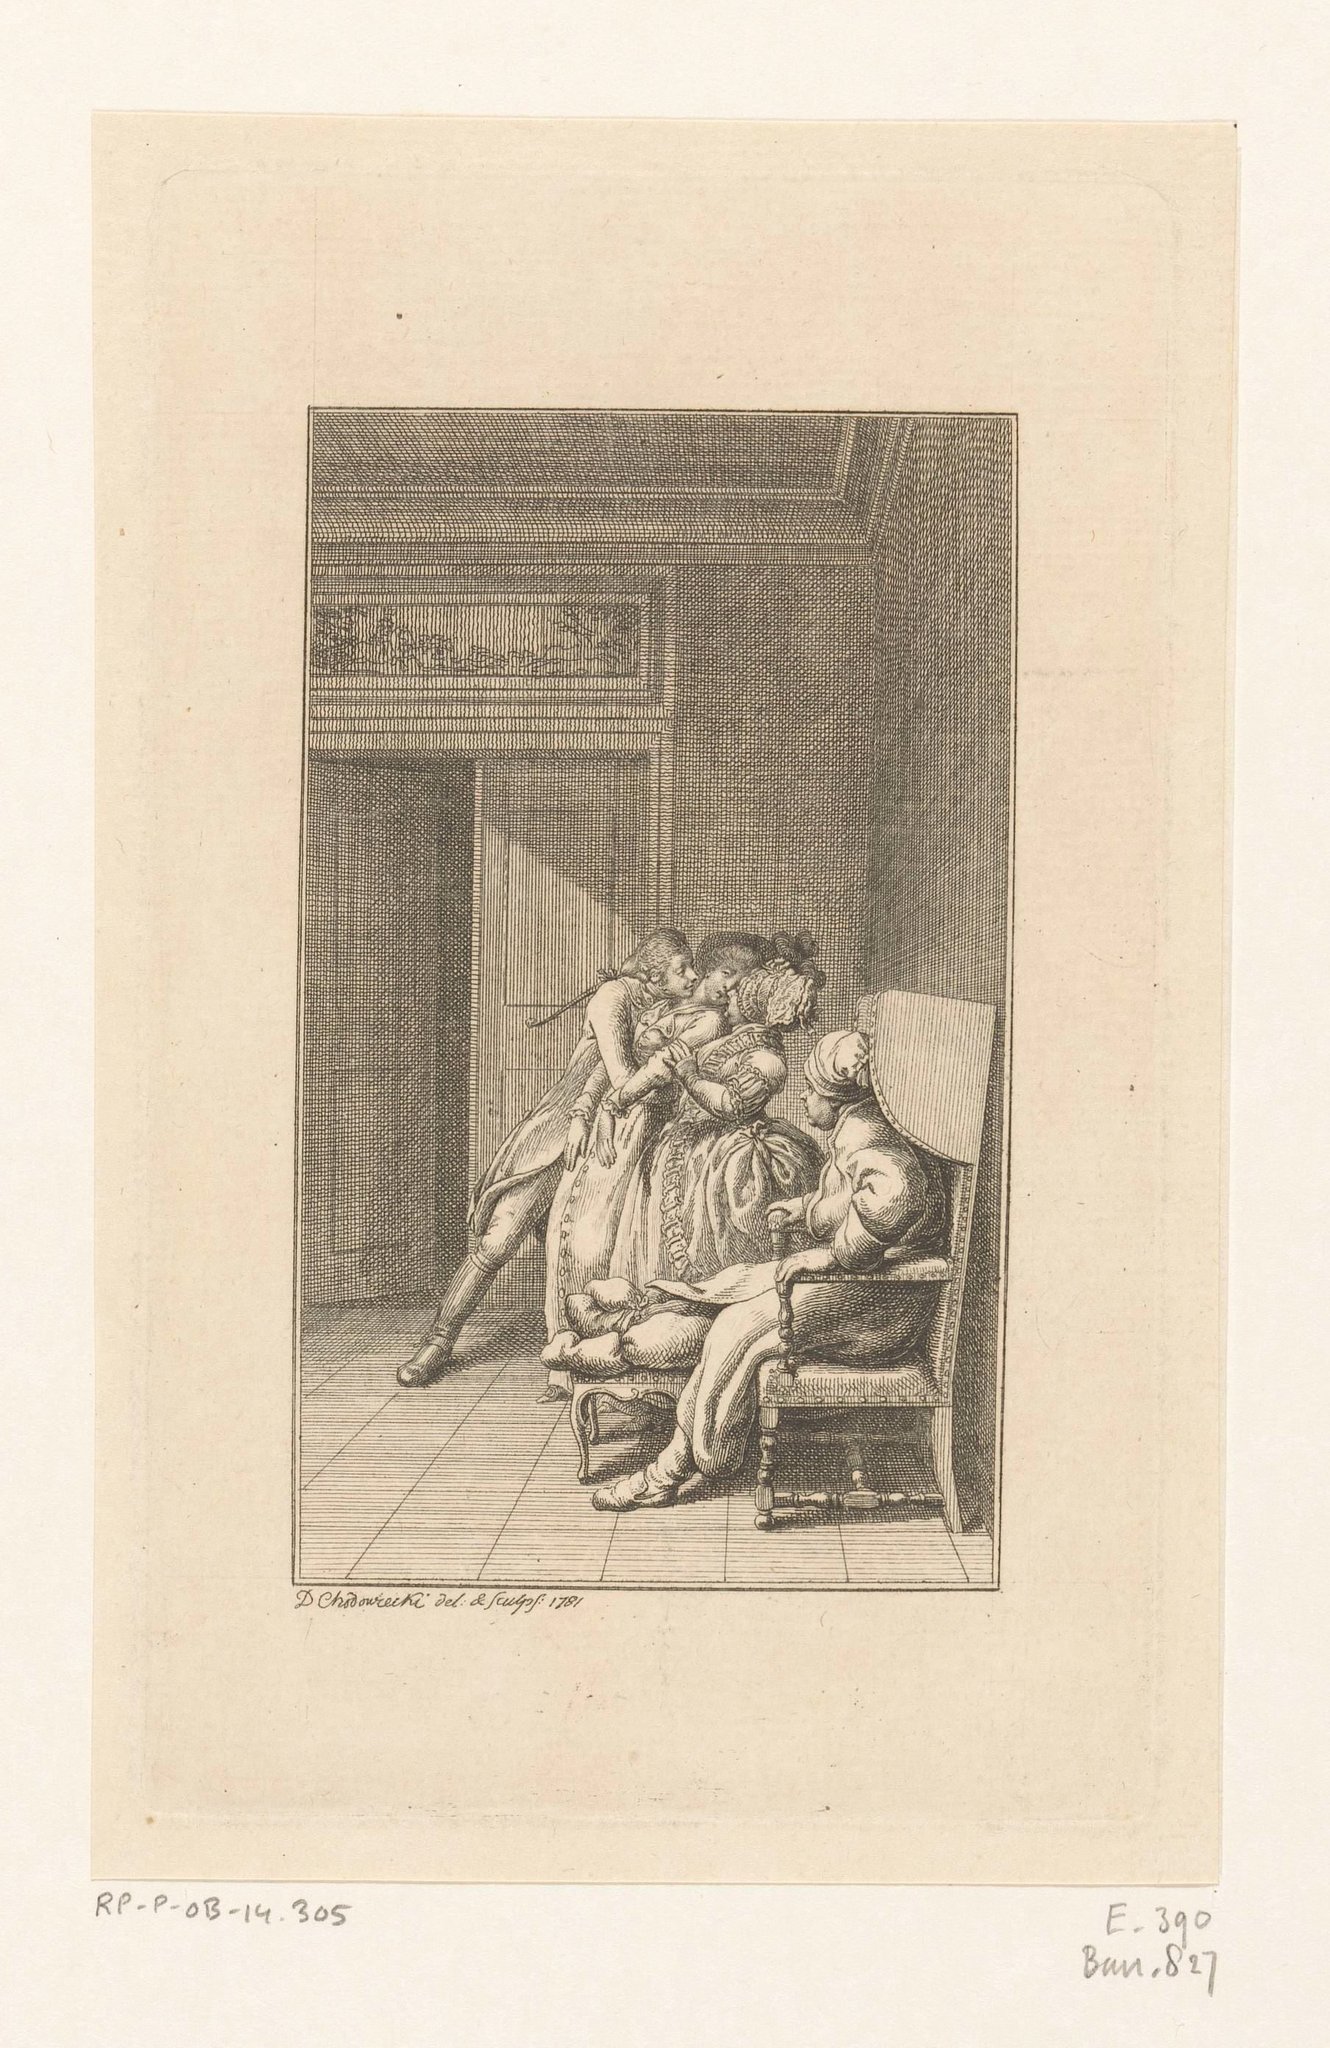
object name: print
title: Amalie von Stolzenbach valt flauw als ze door haar geliefde Philip von Freudenthal wordt verrast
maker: daniel nikolaus chodowiecki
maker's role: draughtsman, print maker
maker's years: 1726-1801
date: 1781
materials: paper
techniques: etching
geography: berlin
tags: fainting, swooning, ankle, (lovers) kissing each other, resting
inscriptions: collector's mark: Lugt 2228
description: Prent gebruikt voor: Philip von Freudenthal, eine Geschichte, so wie sie sich unter dem Monde zugetragen hat. 2 dln. Berlijn: Sigismund Friedrich Hesse, 1781, dl. 1.